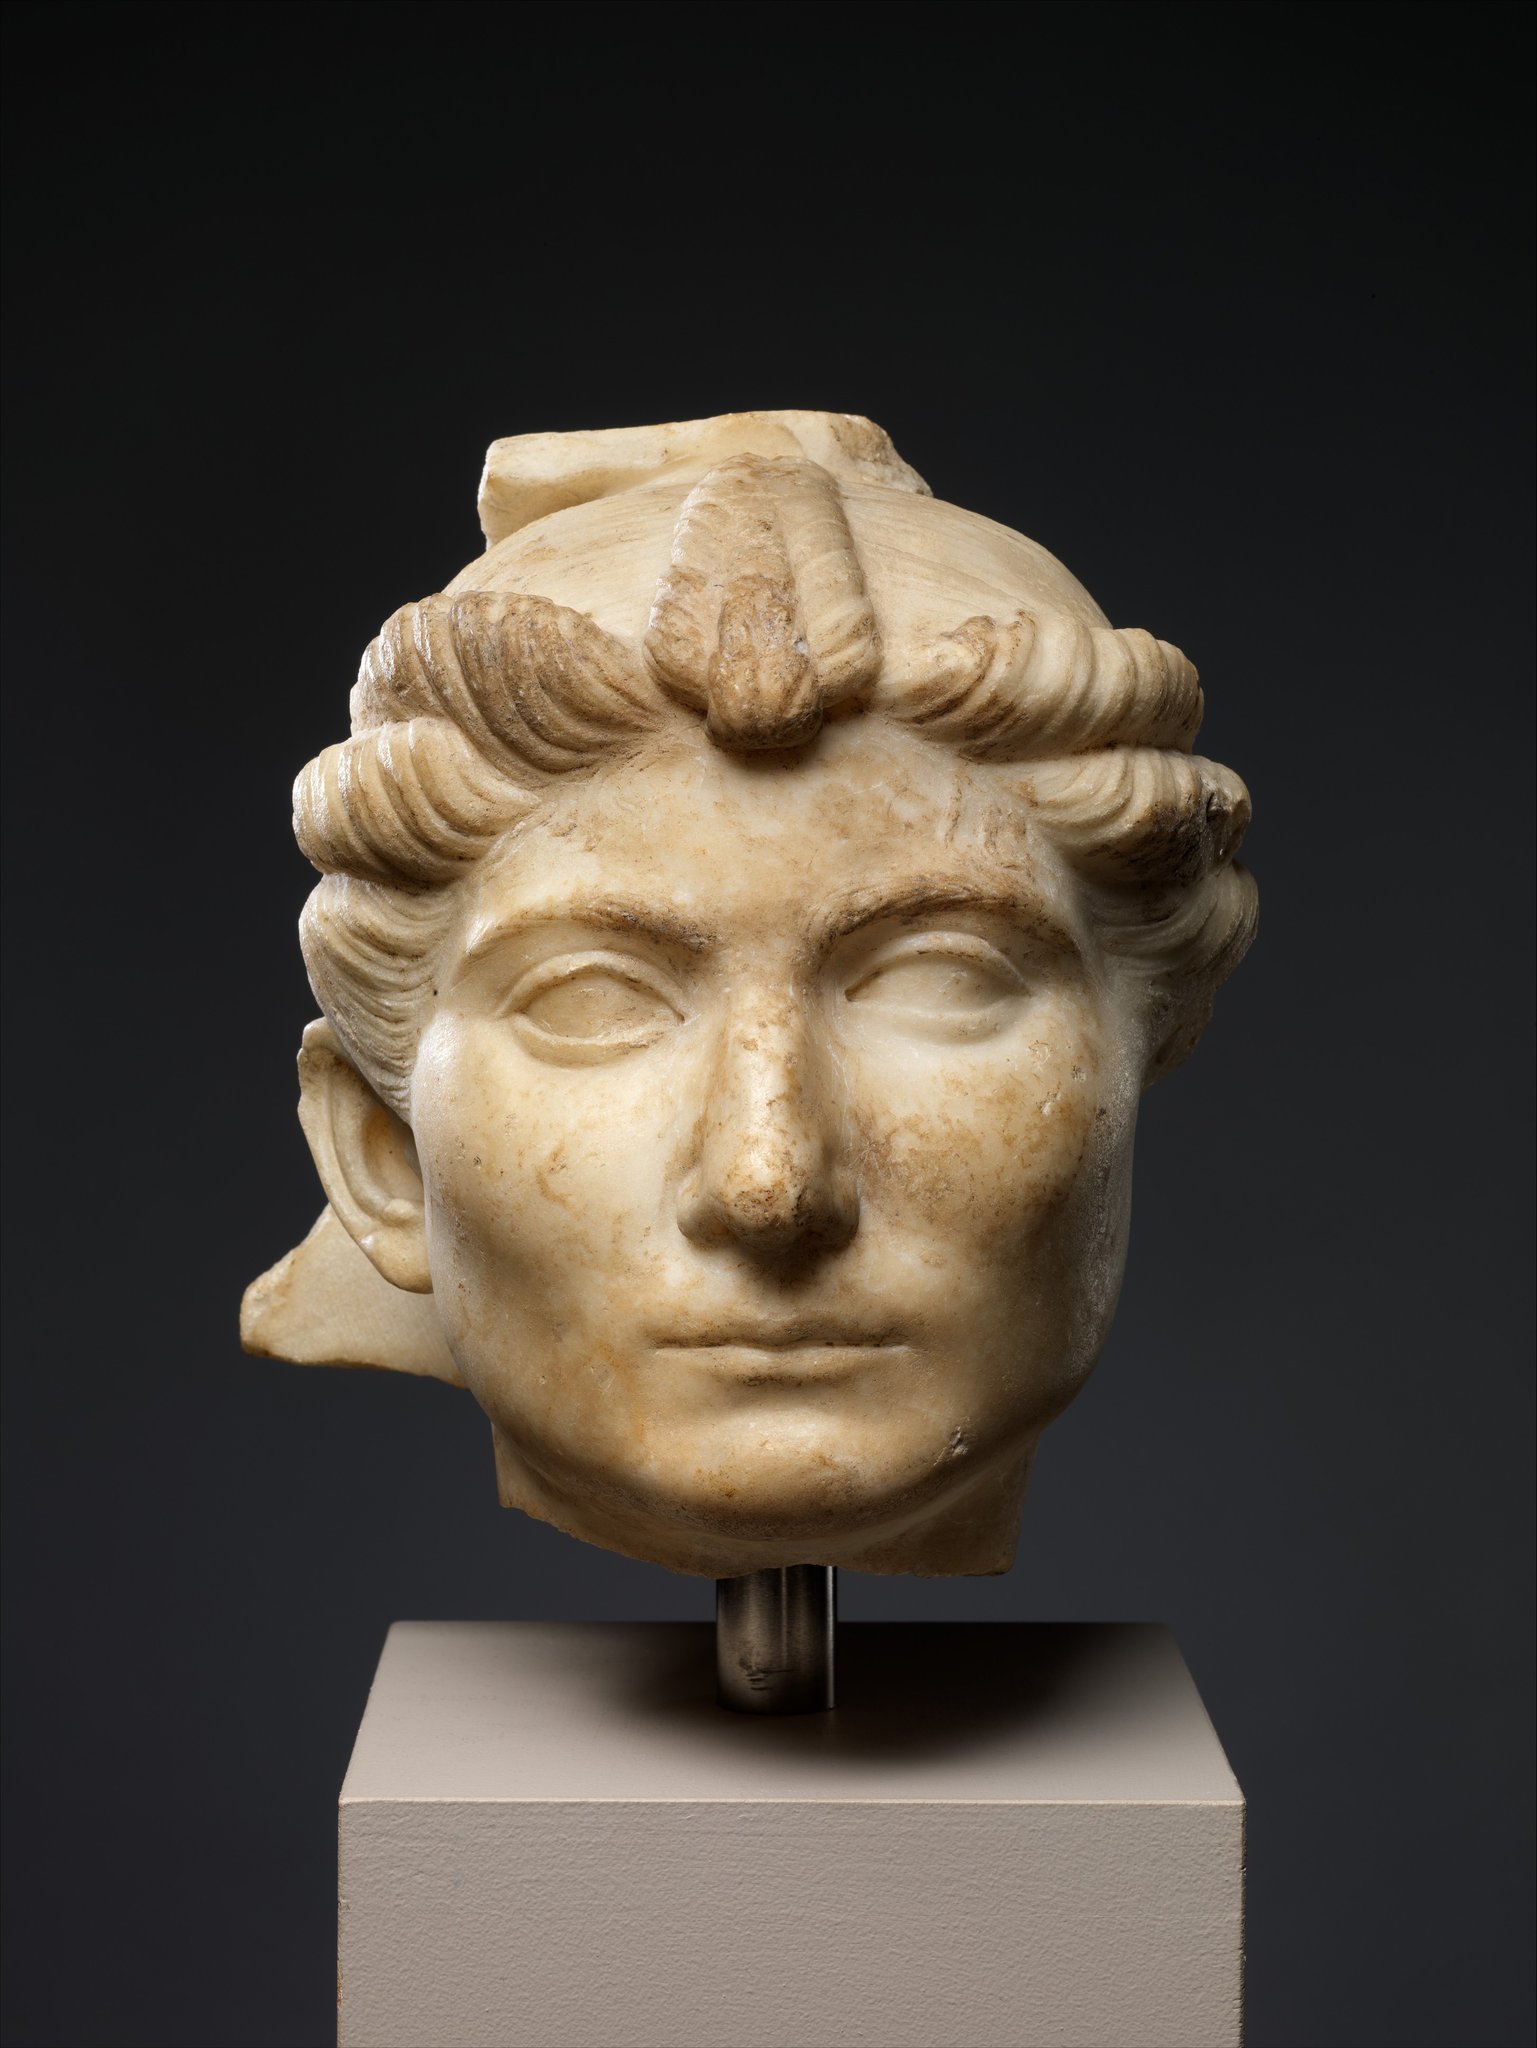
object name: portrait head of a woman from a relief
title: Two marble portrait heads from a relief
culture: roman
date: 13 BCE-5 CE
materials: marble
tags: heads,portraits,women